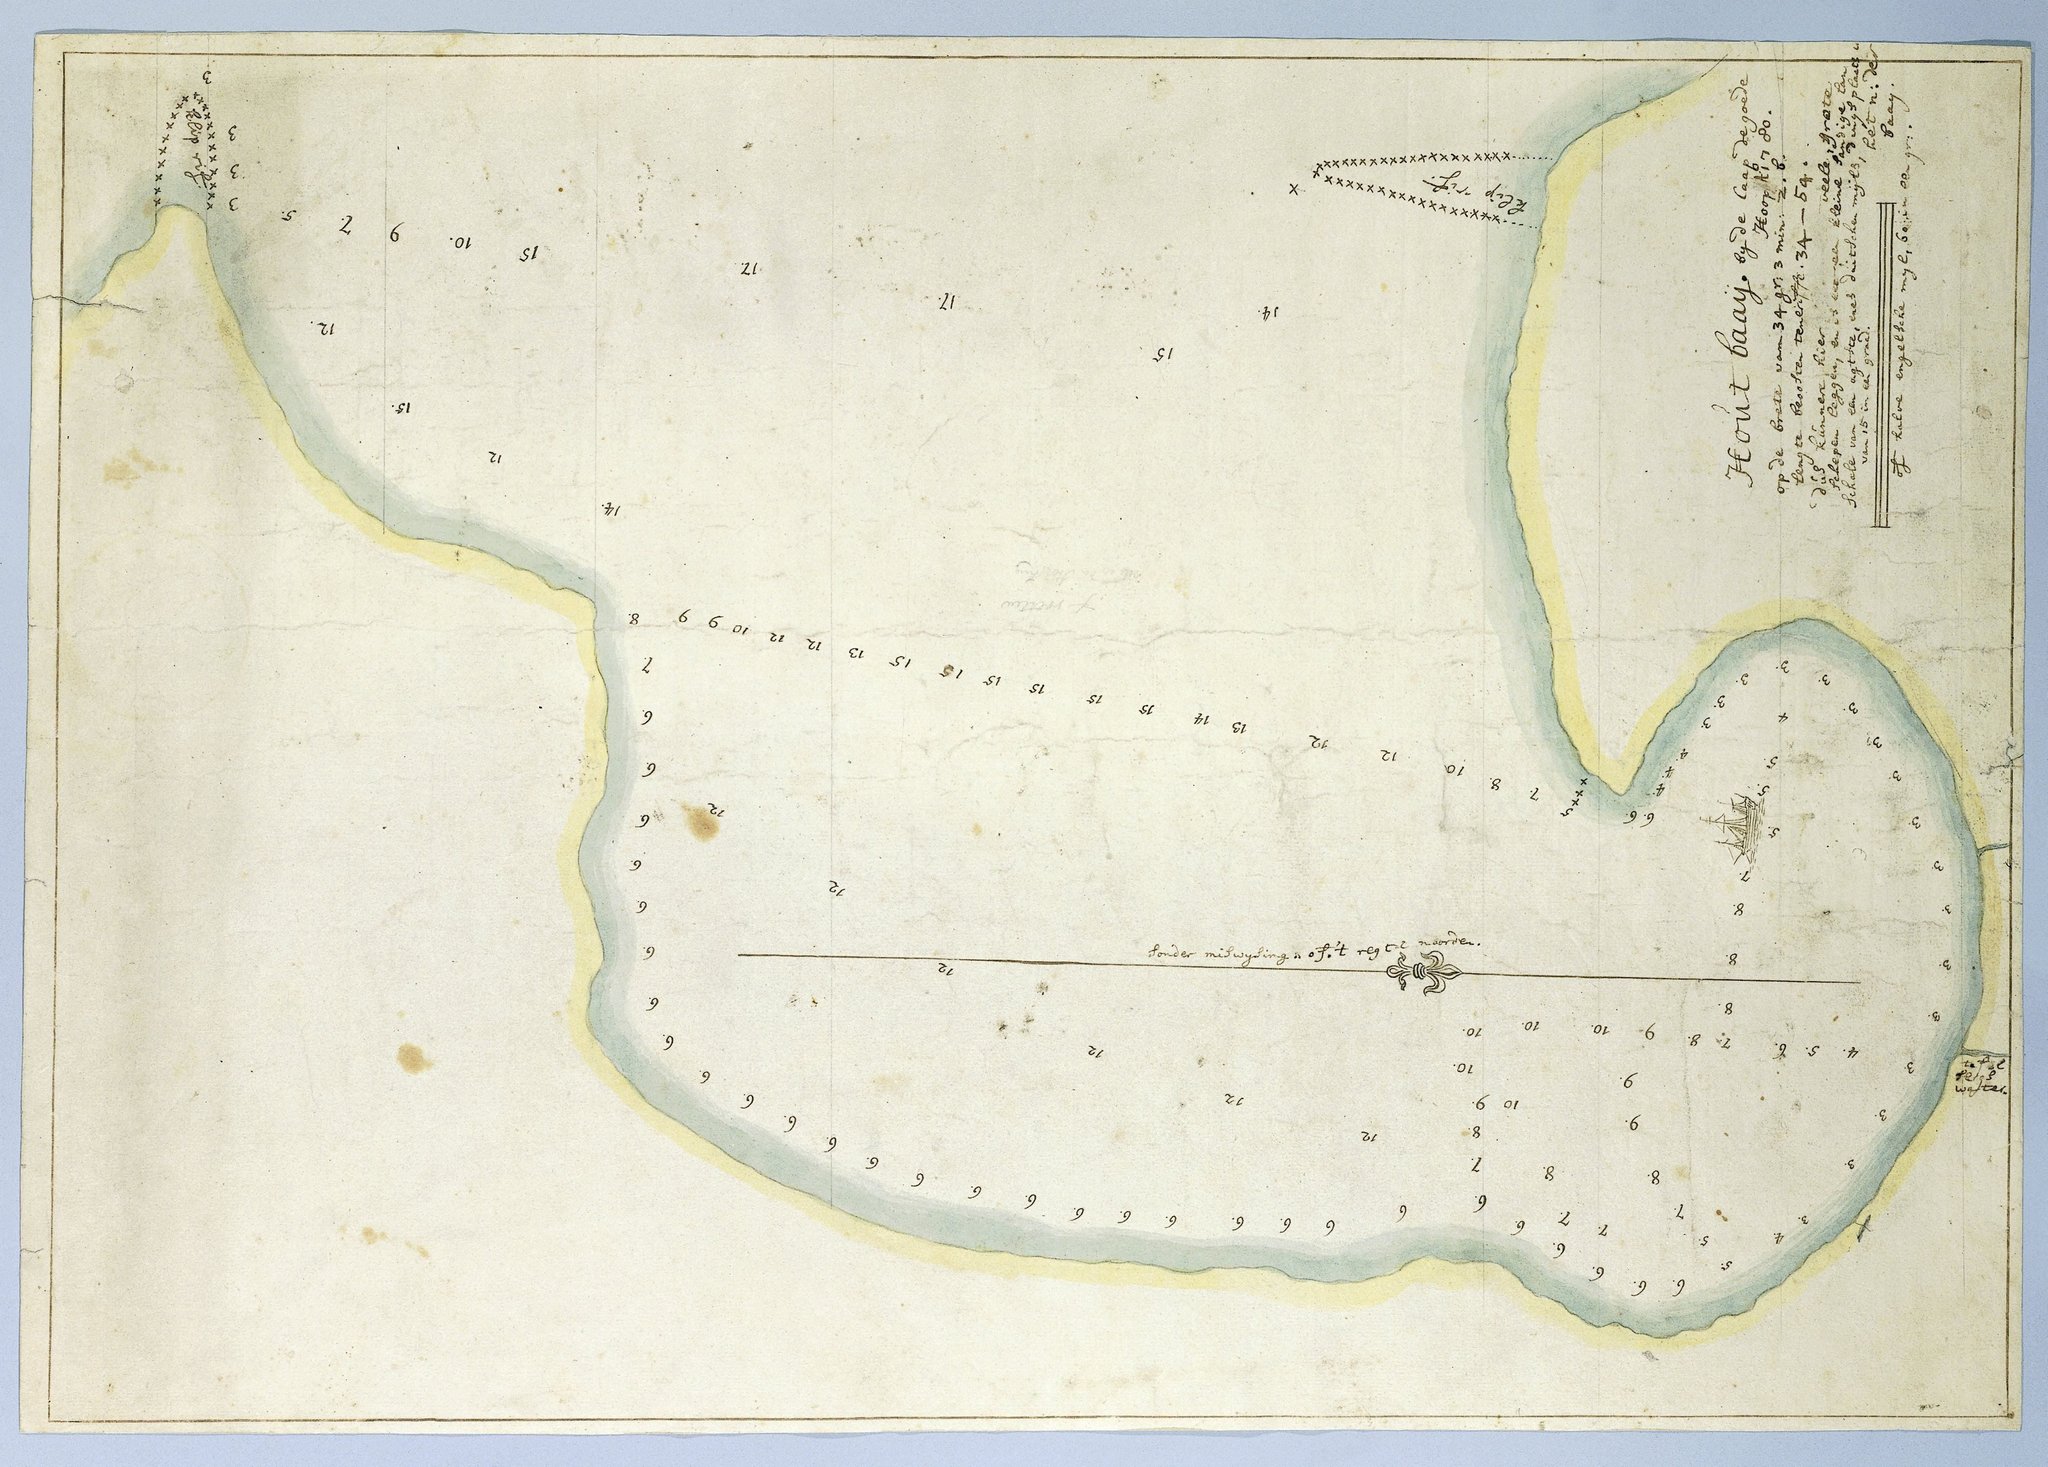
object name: map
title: Map of Hout Bay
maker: robert jacob gordon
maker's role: draughtsman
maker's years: 1743-1795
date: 1780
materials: ink, paper, pencil, watercolor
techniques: brush, pen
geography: cape province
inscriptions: annotation: ‘zie De Jong’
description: Oorspronkelijk in omslag van roodkleurig halfleer en roodgemarmerd plat, dorso met ribben en goudopdruk; 71 x 99 x 6 cm.